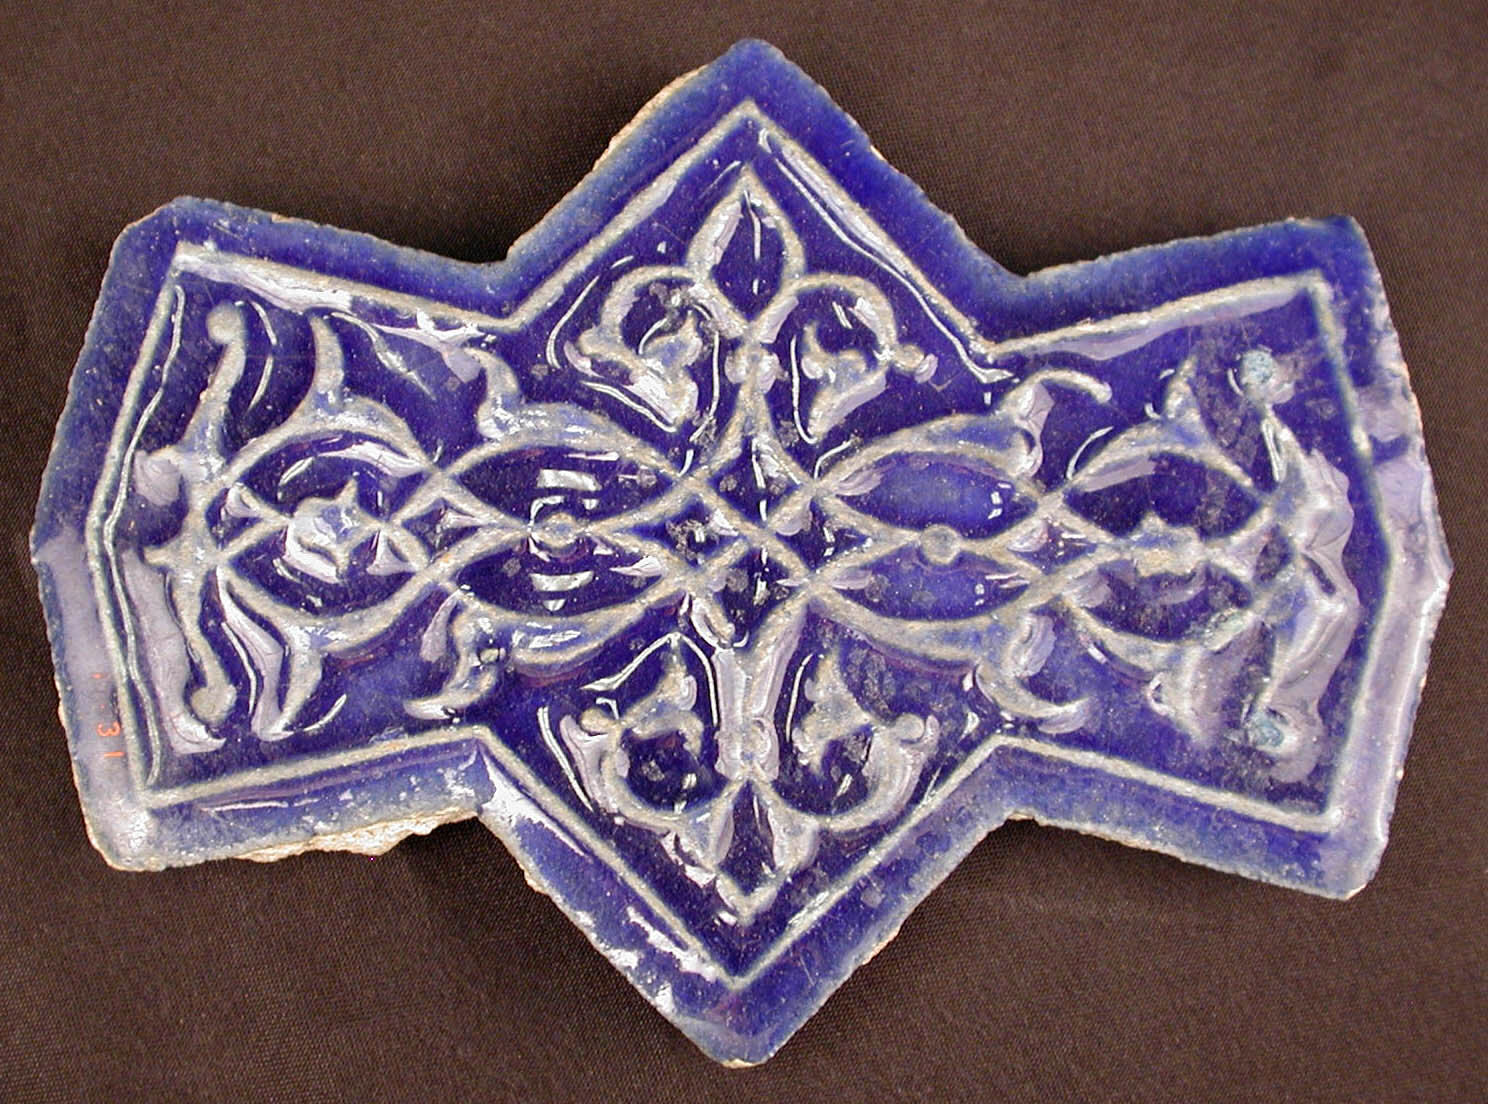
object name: tile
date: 1201-1300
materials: stonepaste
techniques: glazing, molding, painting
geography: iran